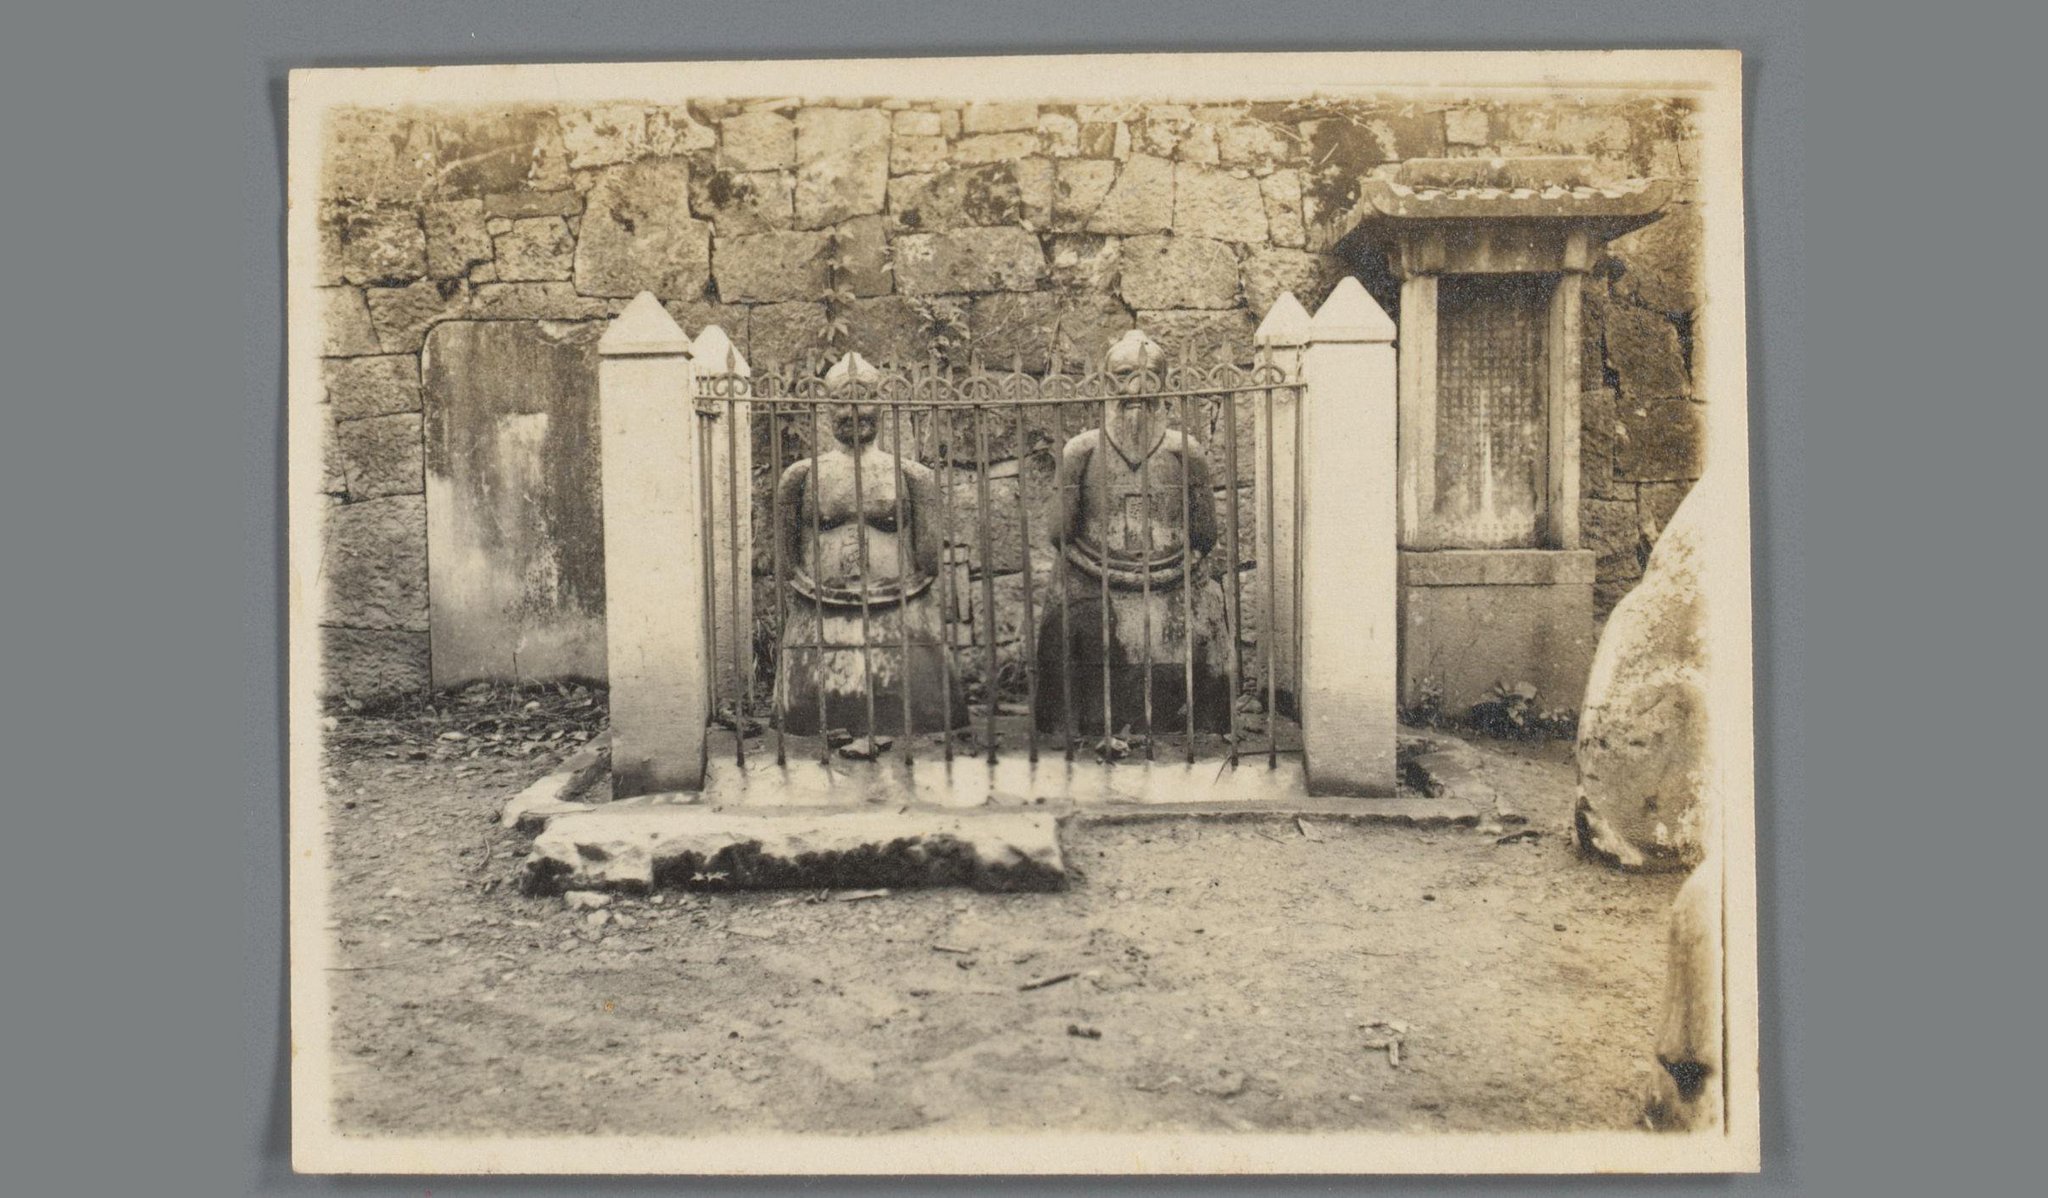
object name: photograph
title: Beelden op een begraafplaats, Shanghai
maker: Anonymous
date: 1910-1930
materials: paper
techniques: gelatin silver print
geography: shanghai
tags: cemetery, park-like burying ground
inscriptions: stamp: ‘Copyright Photograph by Mactavish & Co., Ltd./ Shanghai.’